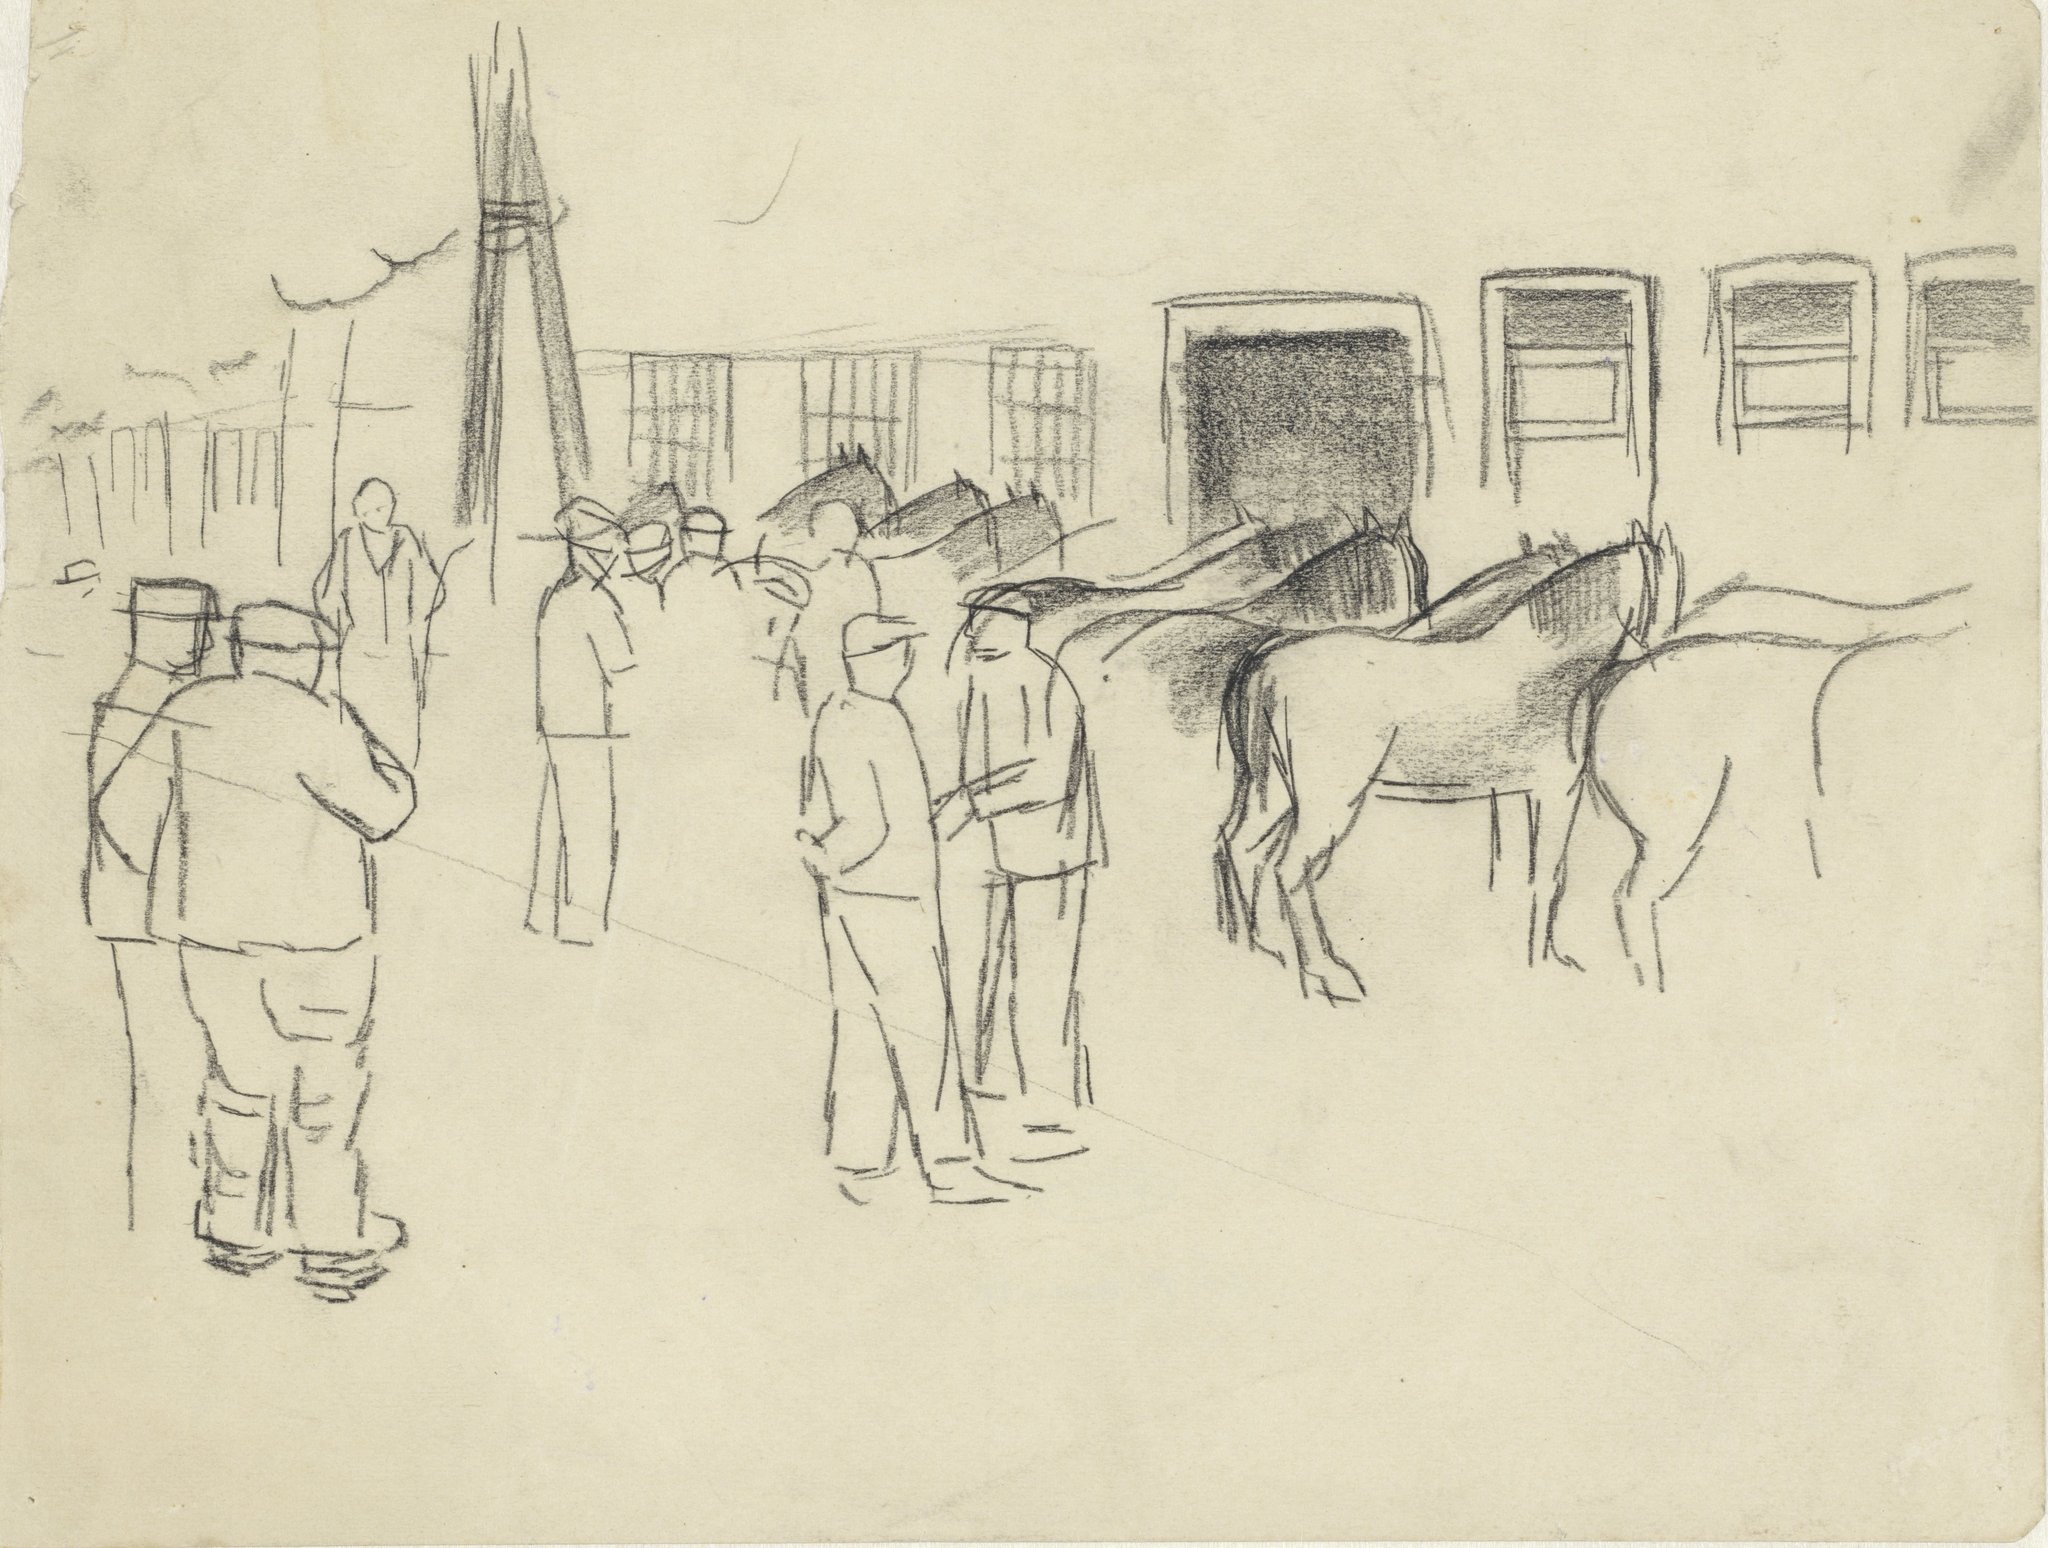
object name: drawing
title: Paardenmarkt met diverse figuren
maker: henk henriët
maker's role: draughtsman, print maker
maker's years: 1903-1945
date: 1913-1945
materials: chalk, paper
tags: standing figure, horse, market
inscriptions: collector's mark: Lugt 2228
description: Een rij paarden staat voor een gebouw met ramen. Bij de paarden staan groepjes mannen die met elkaar in gesprek zijn.